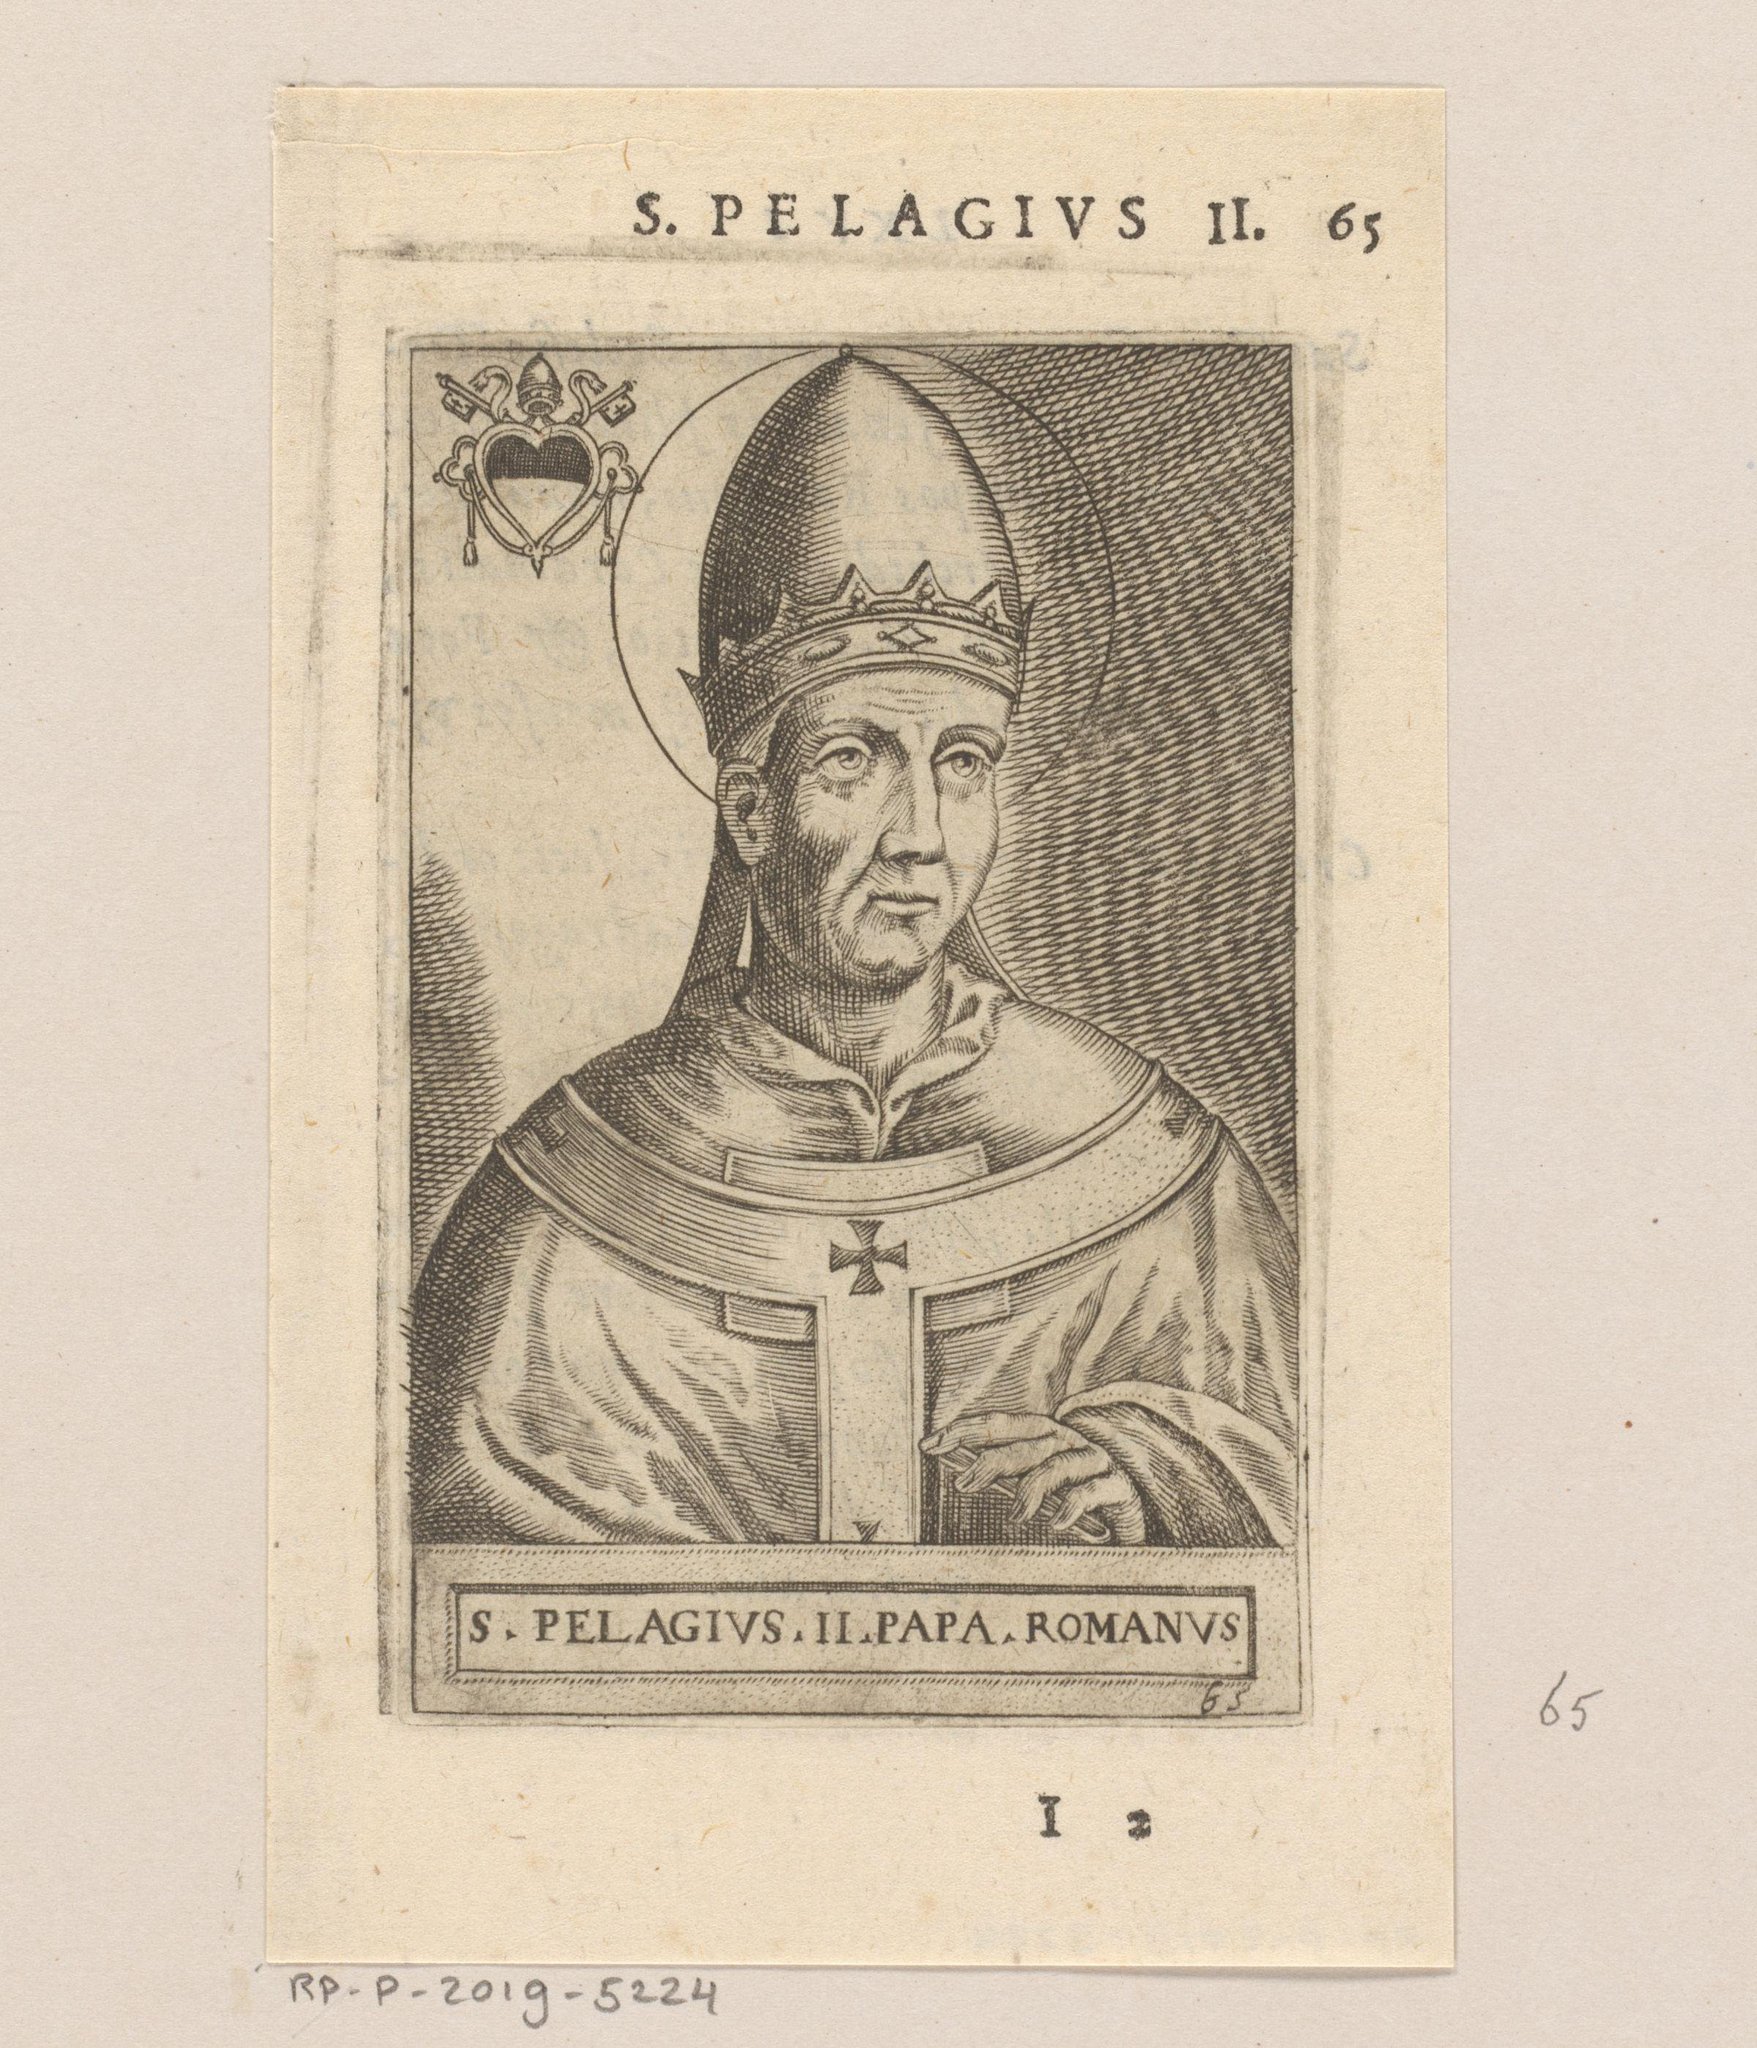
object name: book illustration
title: Portret van paus Pelagius II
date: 1595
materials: paper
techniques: engraving, letterpress printing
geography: rome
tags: historical persons, pope, armorial bearing, heraldry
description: Prent uit: Cavalieri, Giovanni Battista de'. Effigies pontificum romanorum cum eorum vitis (...). Rome: Bartolomeo Bonfadino, 1595. Prent voor het eerst verschenen in: Cavalieri, Giovanni Battista de'. Pontificum romanorum effigies (...). Rome: Domenico Basa en Francesco Zanetti, 1580. Prent ook gebruikt in latere publicaties.